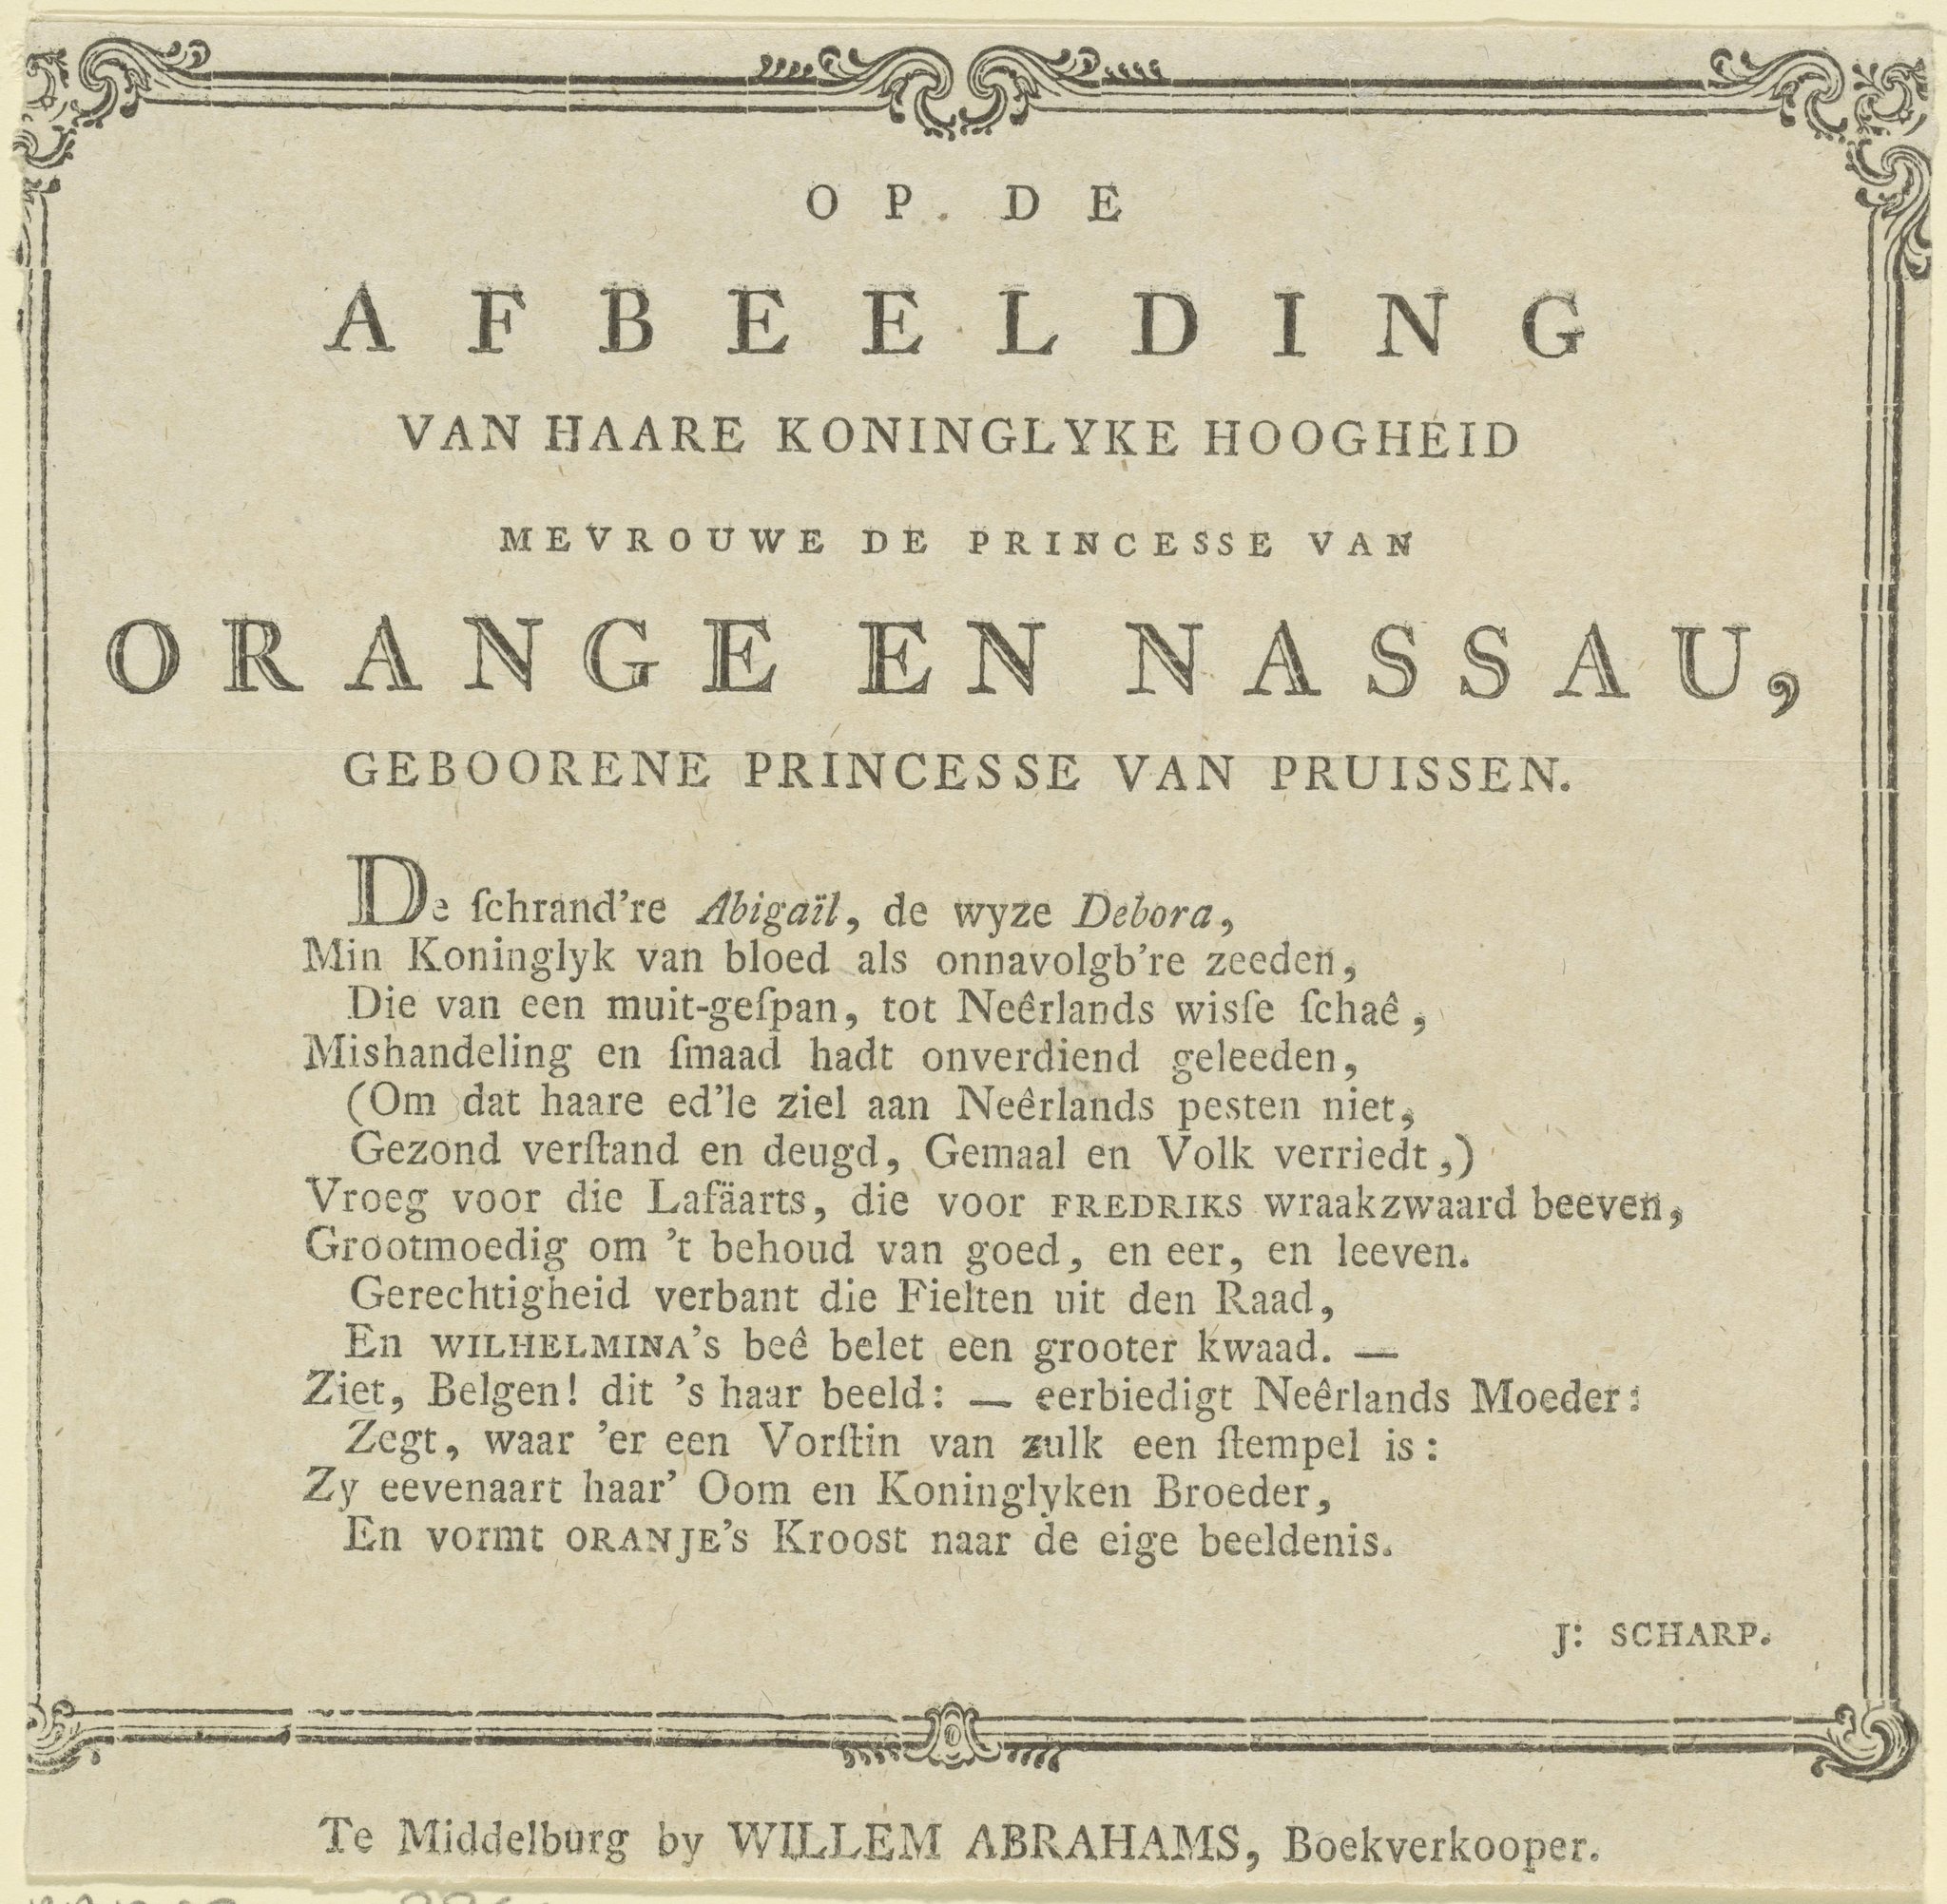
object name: text sheet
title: Tekst bij het portret van Wilhelmina van Pruisen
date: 1767-1791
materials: paper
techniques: letterpress printing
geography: middelburg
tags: berlin, painter, wilhelmina of prussia (princess of orange)